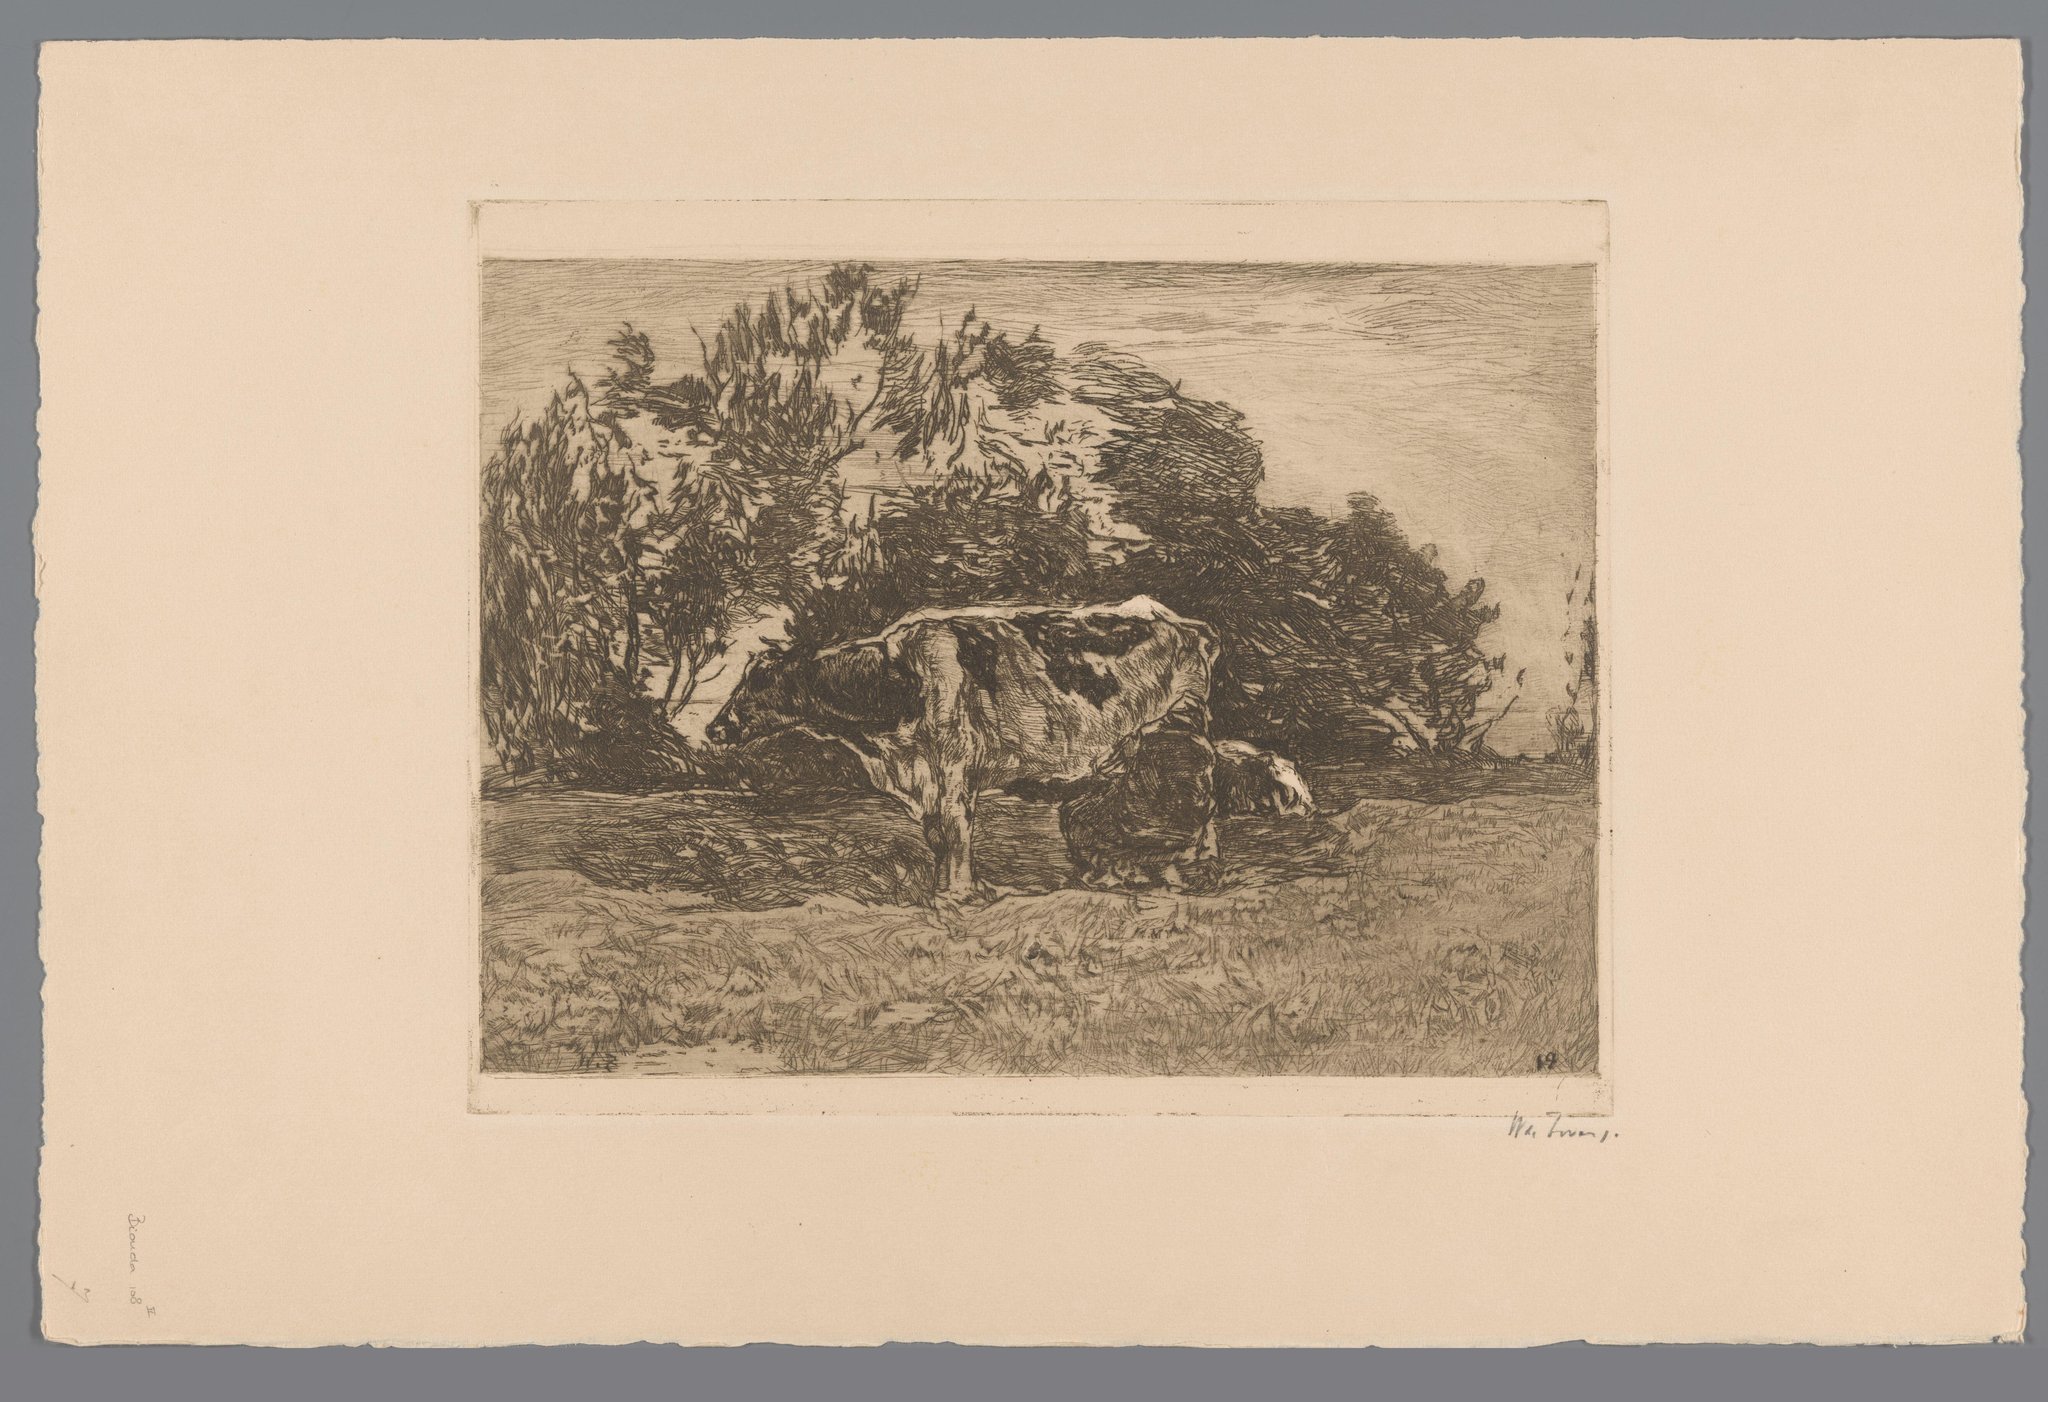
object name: print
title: Melkende boer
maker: willem de zwart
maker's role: draughtsman, painter, print maker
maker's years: 1862-1931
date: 1924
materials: paper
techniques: drypoint, etching, intaglio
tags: cow, meadow, pasture, milking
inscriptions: collector's mark: Lugt 2228, collector's mark: Lugt 2760